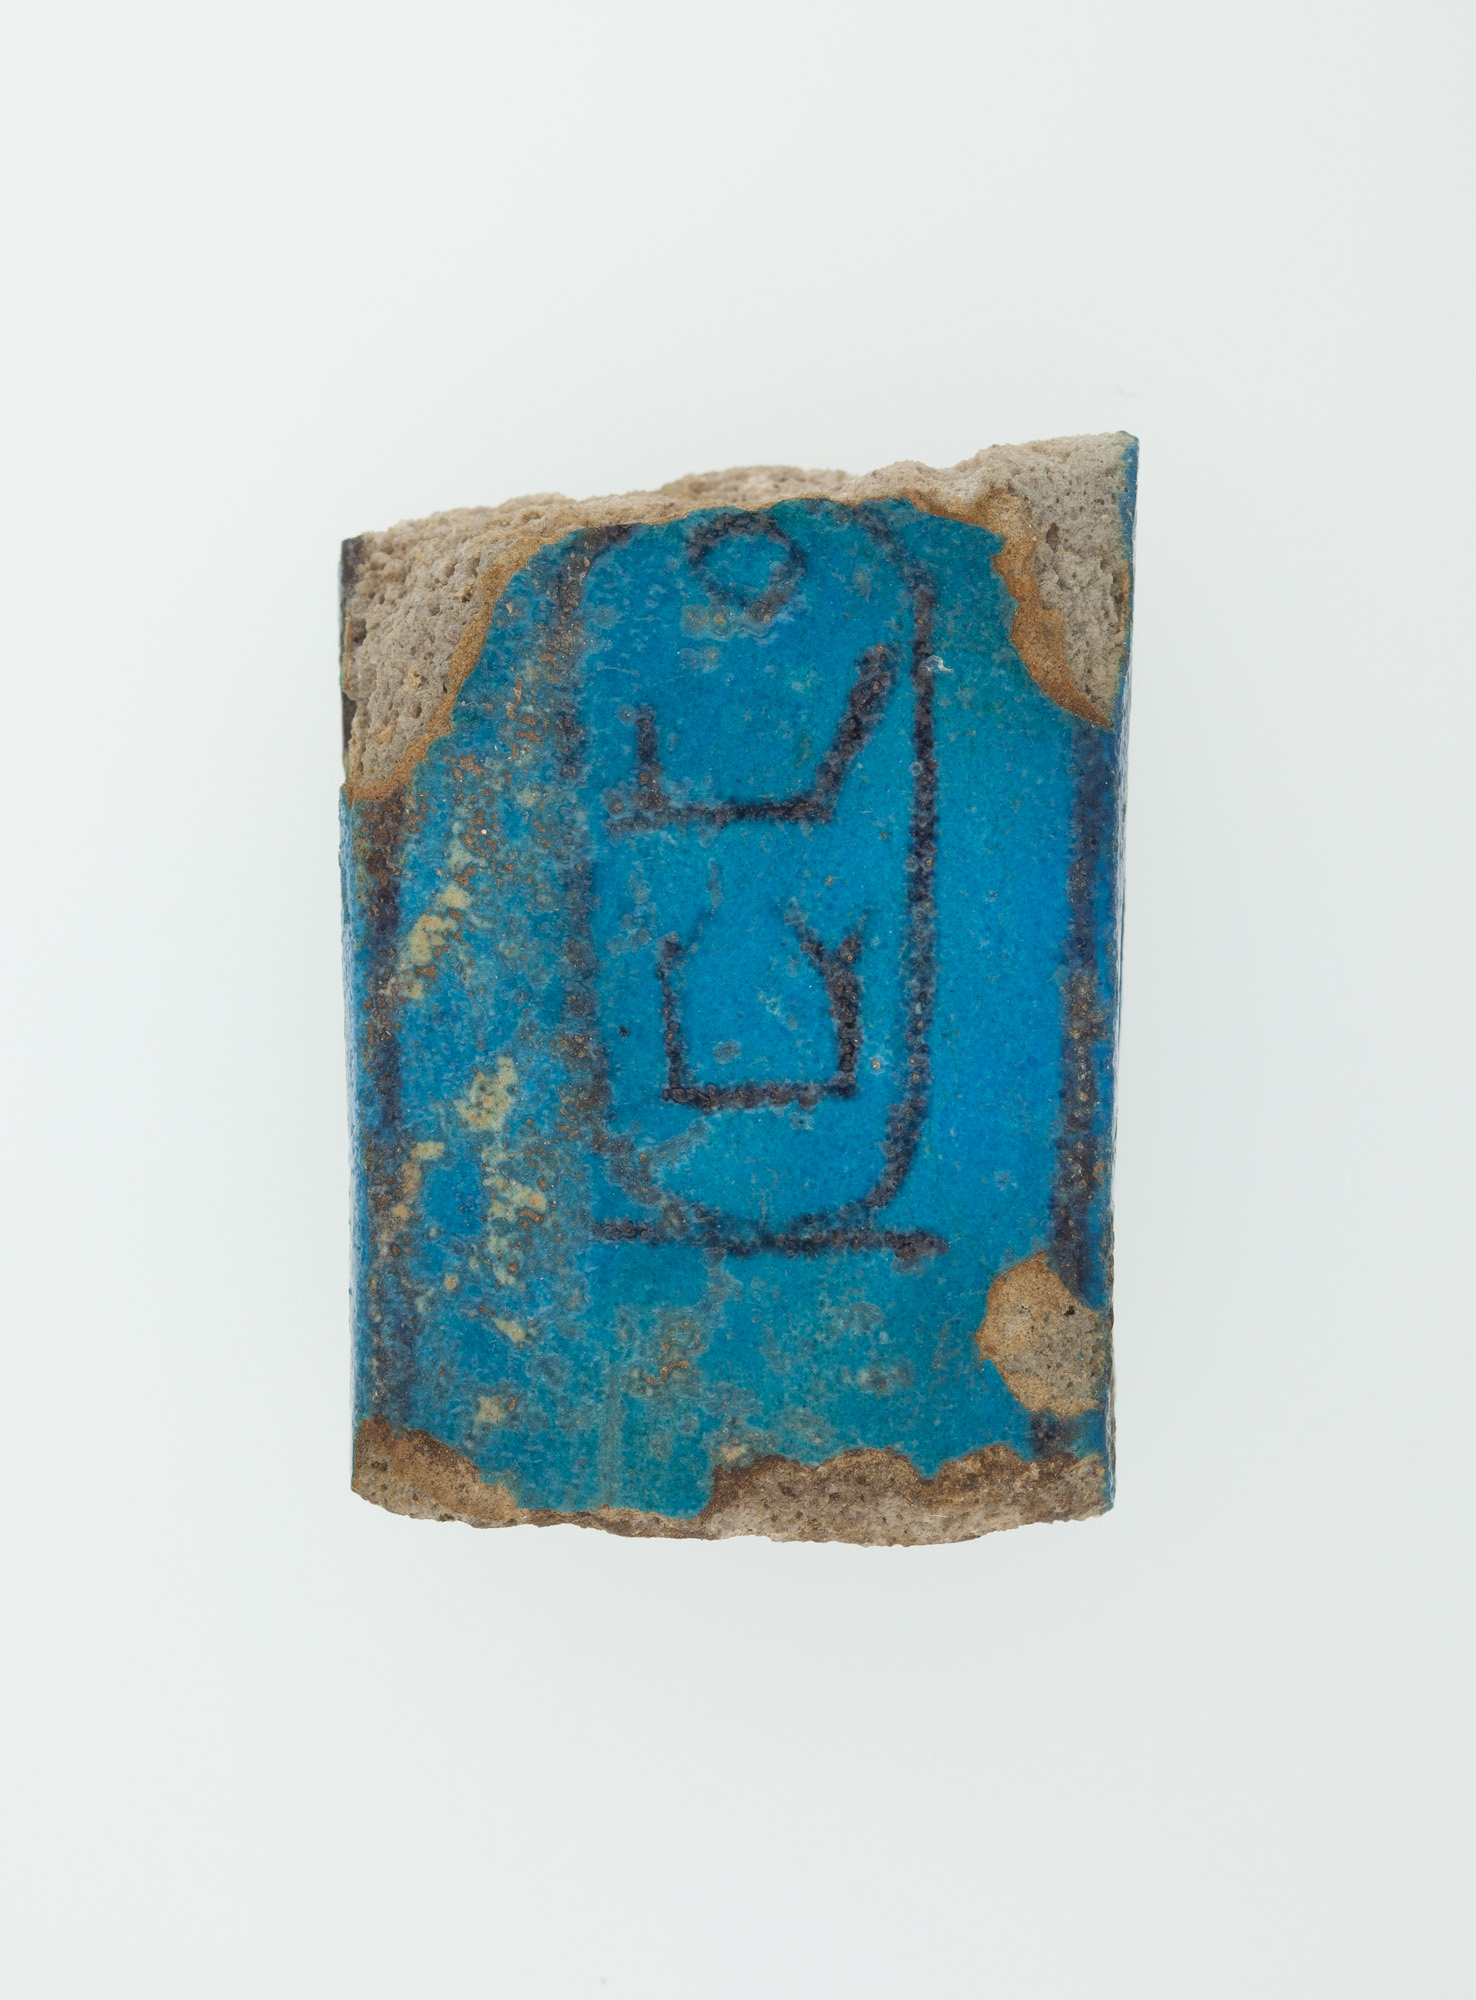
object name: menat fragment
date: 1479-1458 BCE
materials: faience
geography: egypt